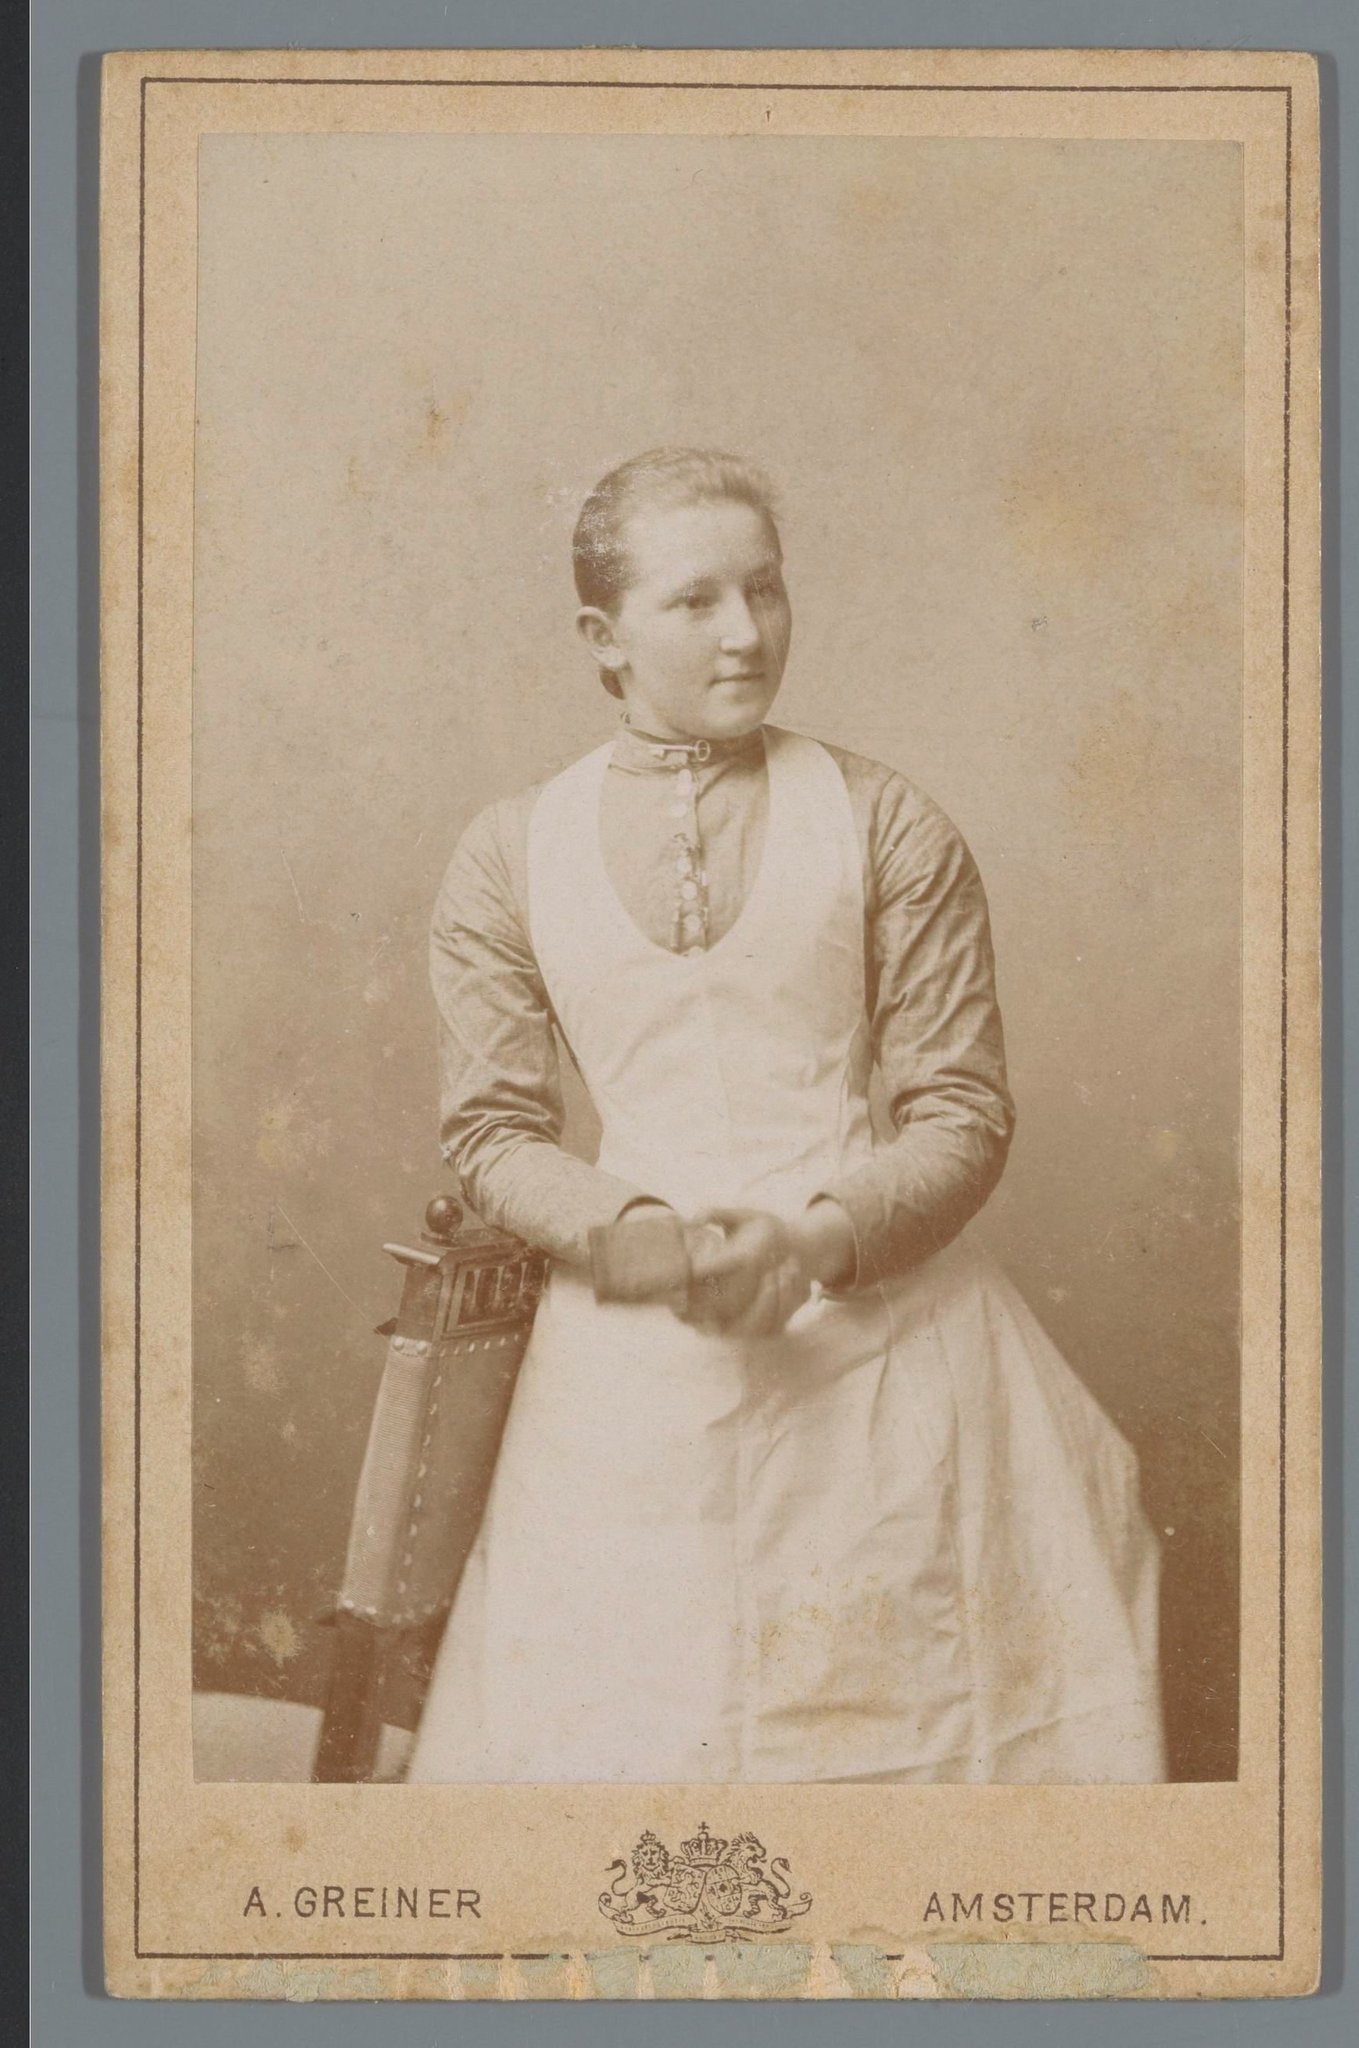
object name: photograph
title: Carte-de-visite Portraits of Domestic Workers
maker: albert greiner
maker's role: fotograaf, fotostudio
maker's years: 1833-1890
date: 1883-1887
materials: cardboard, photographic support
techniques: daylight paper print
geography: amsterdam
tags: historical persons - bb - woman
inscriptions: inscription: ‘ALBERT GREINER/ Photograaf van wijlen Z.M. den/ Koning Willem III en H.M. de Koningin Weduwe./ AMSTERDAM/ (...) AMSTERDAM 1883 (...)/NIEUWENDIJK 89./ Specialiteit in Vergrootingen.’, inscription: ‘Overl/ Lina Hamming/ 92.. Amsterdam/ Buitengasthuis./ dochter v Bertus Hamming/ zoon v H. Hamming’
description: The woman in the upper left photograph is Lina Hamming, a domestic worker in Amsterdam. Hamming was one of thousands of women who worked in the households of wealthy families. We do not know the names of the other women, but we do know their occupation: domestic workers. They wore the characteristic white aprons and caps. The baskets and the dustpan and brush indicate their duties in the household.